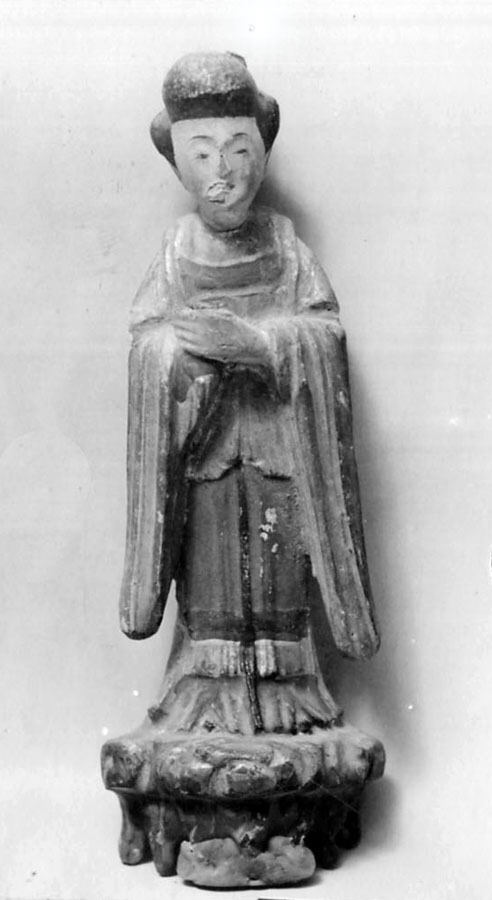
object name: statuette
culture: chinese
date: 1701-1800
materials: wood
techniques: painting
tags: men